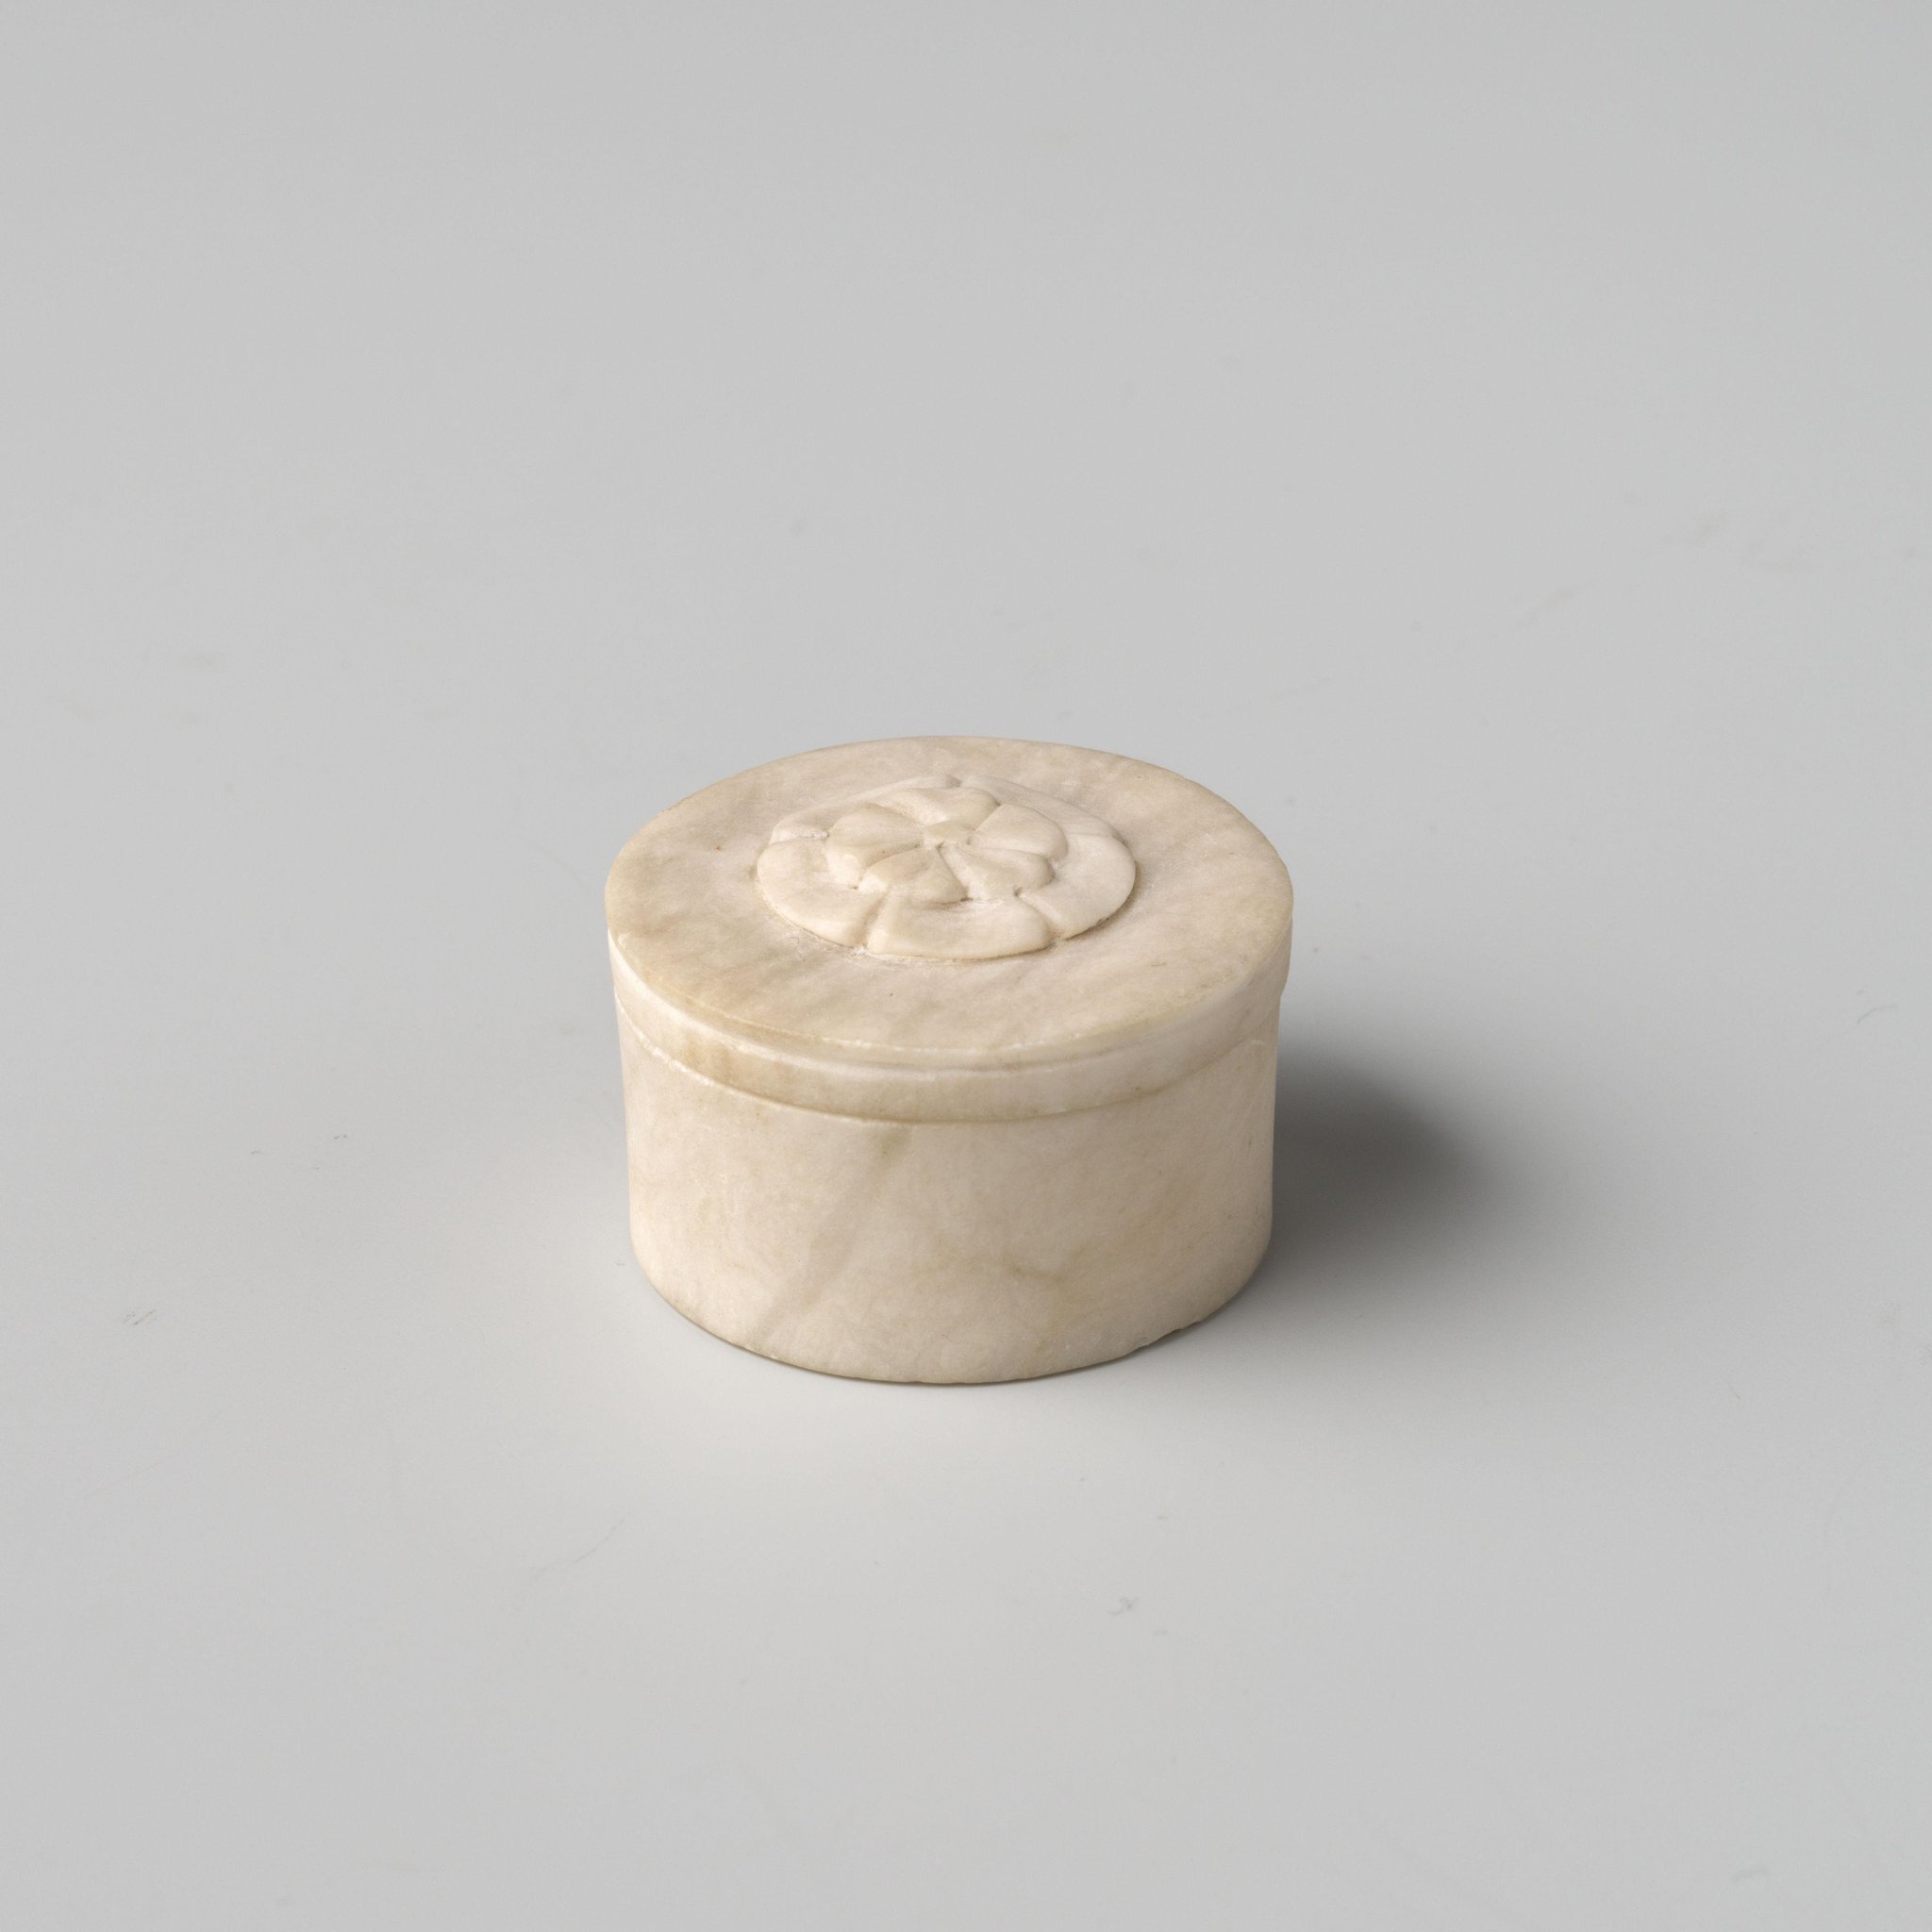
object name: miniature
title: Doos van albast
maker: Anonymous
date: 1650-1699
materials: alabaster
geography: netherlands